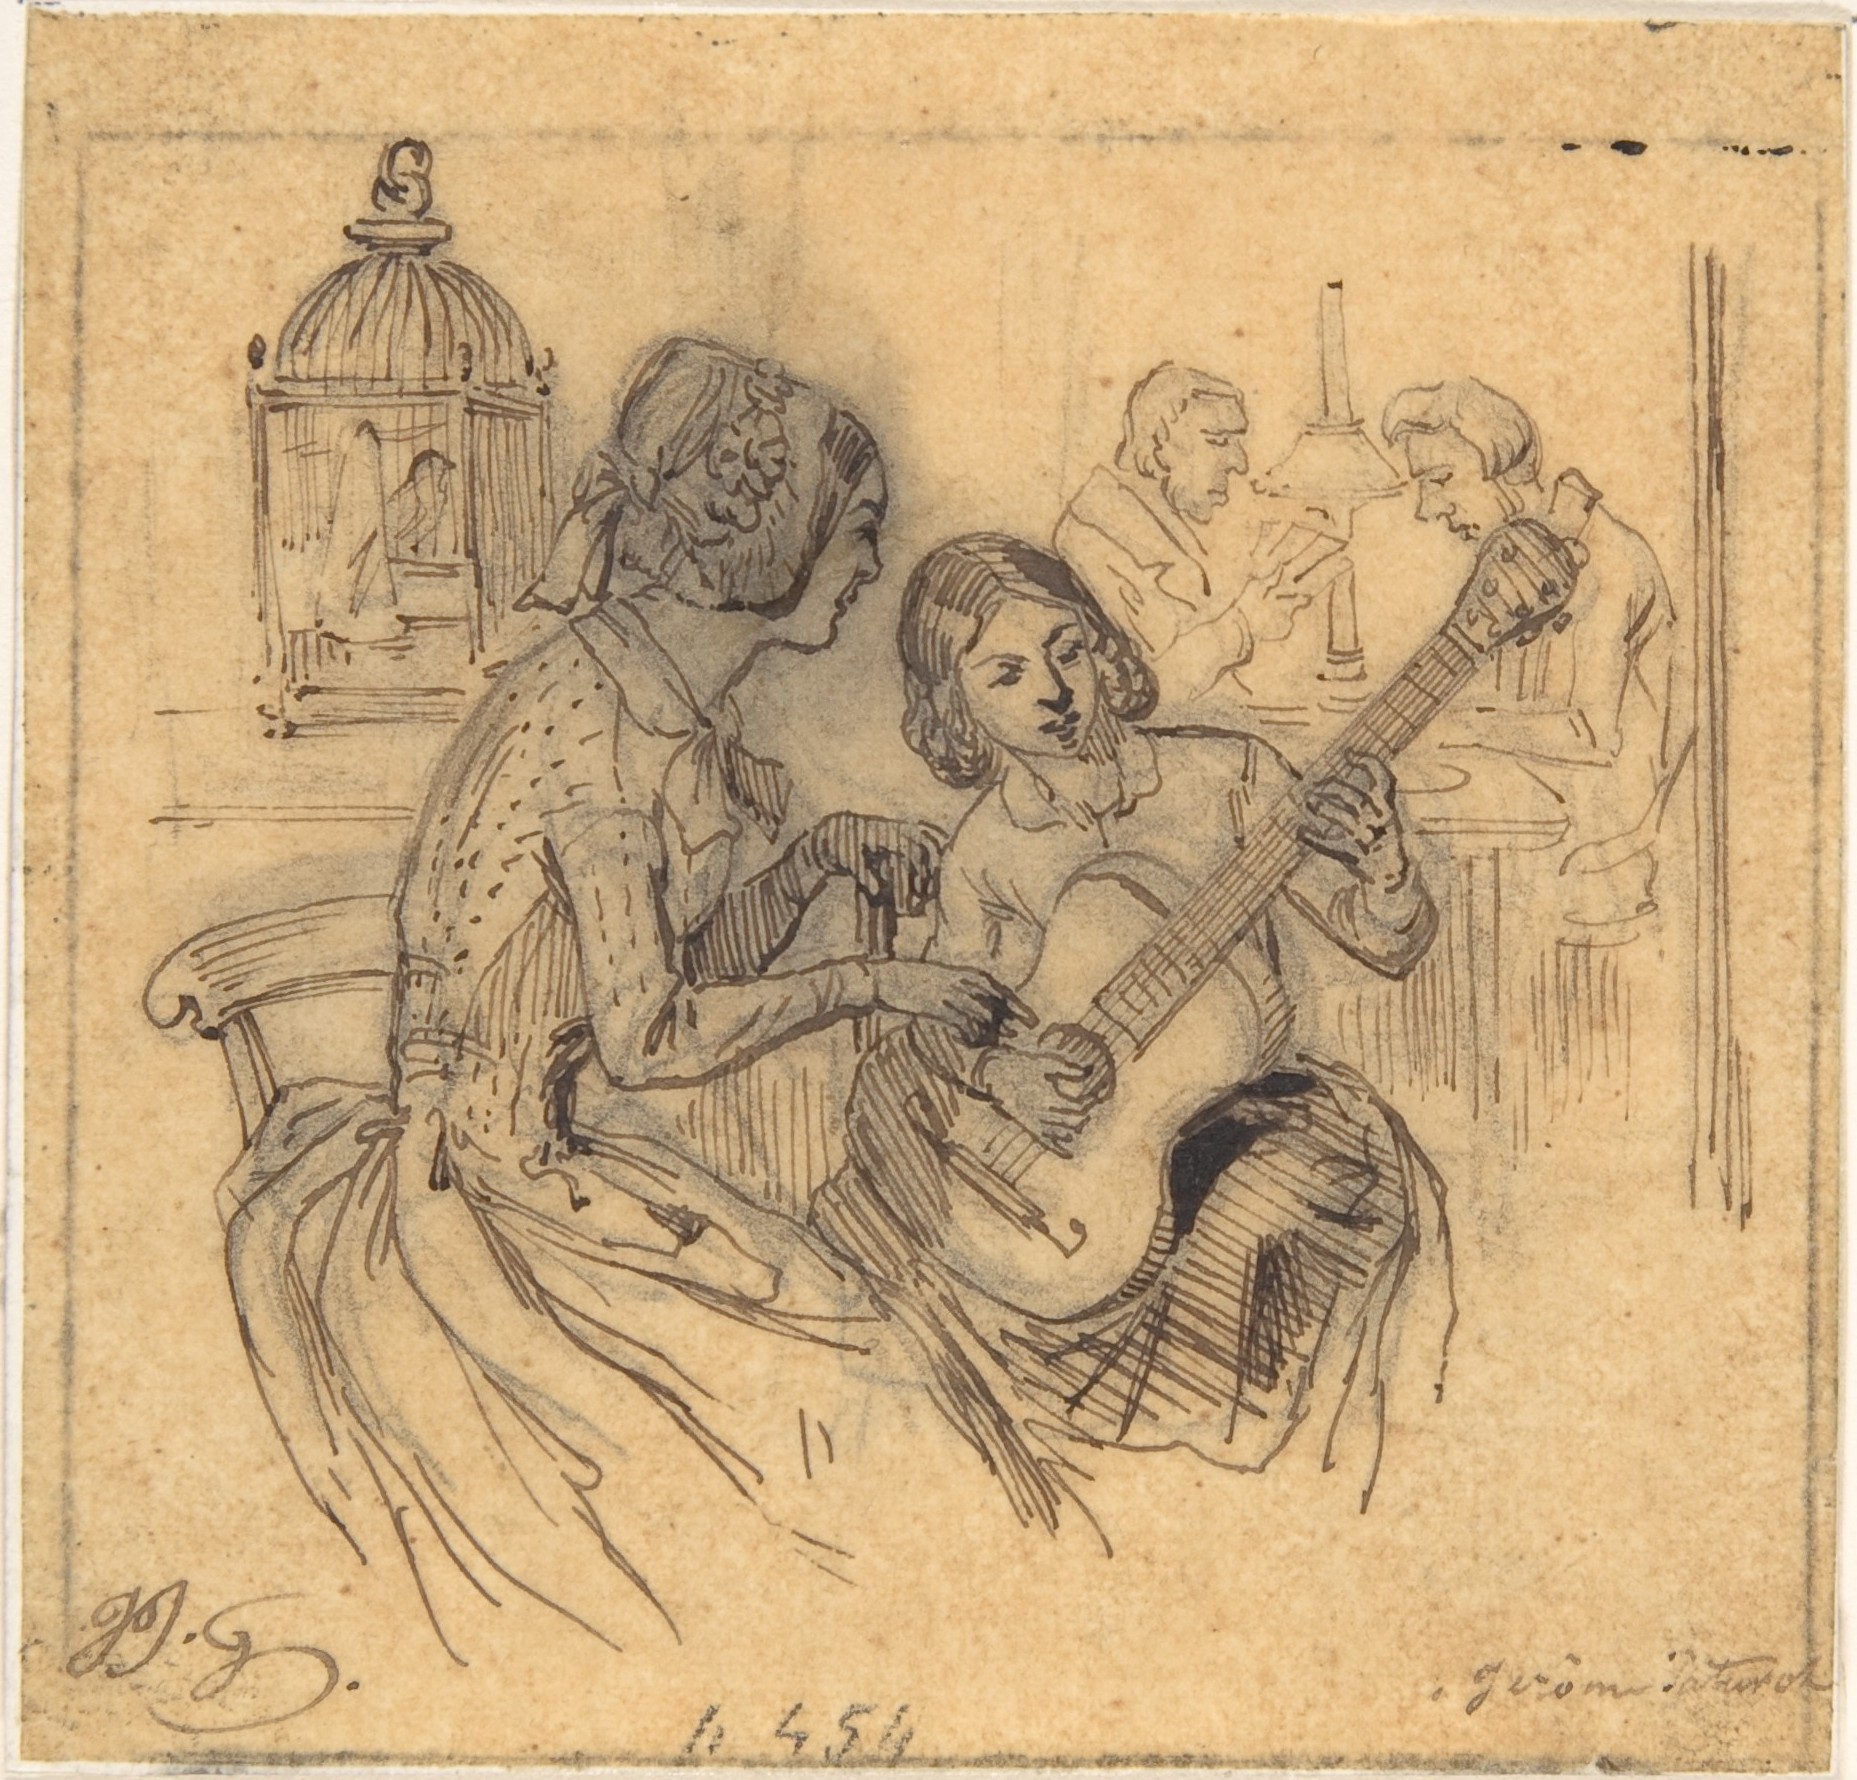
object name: drawing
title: Illustration in Jérôme Paturot, by Louis Reybaud, Paris, 1846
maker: j. j. grandville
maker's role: artist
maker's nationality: french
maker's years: 1803-1847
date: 1846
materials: graphite, ink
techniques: pen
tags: birds,girls,men,women,guitars